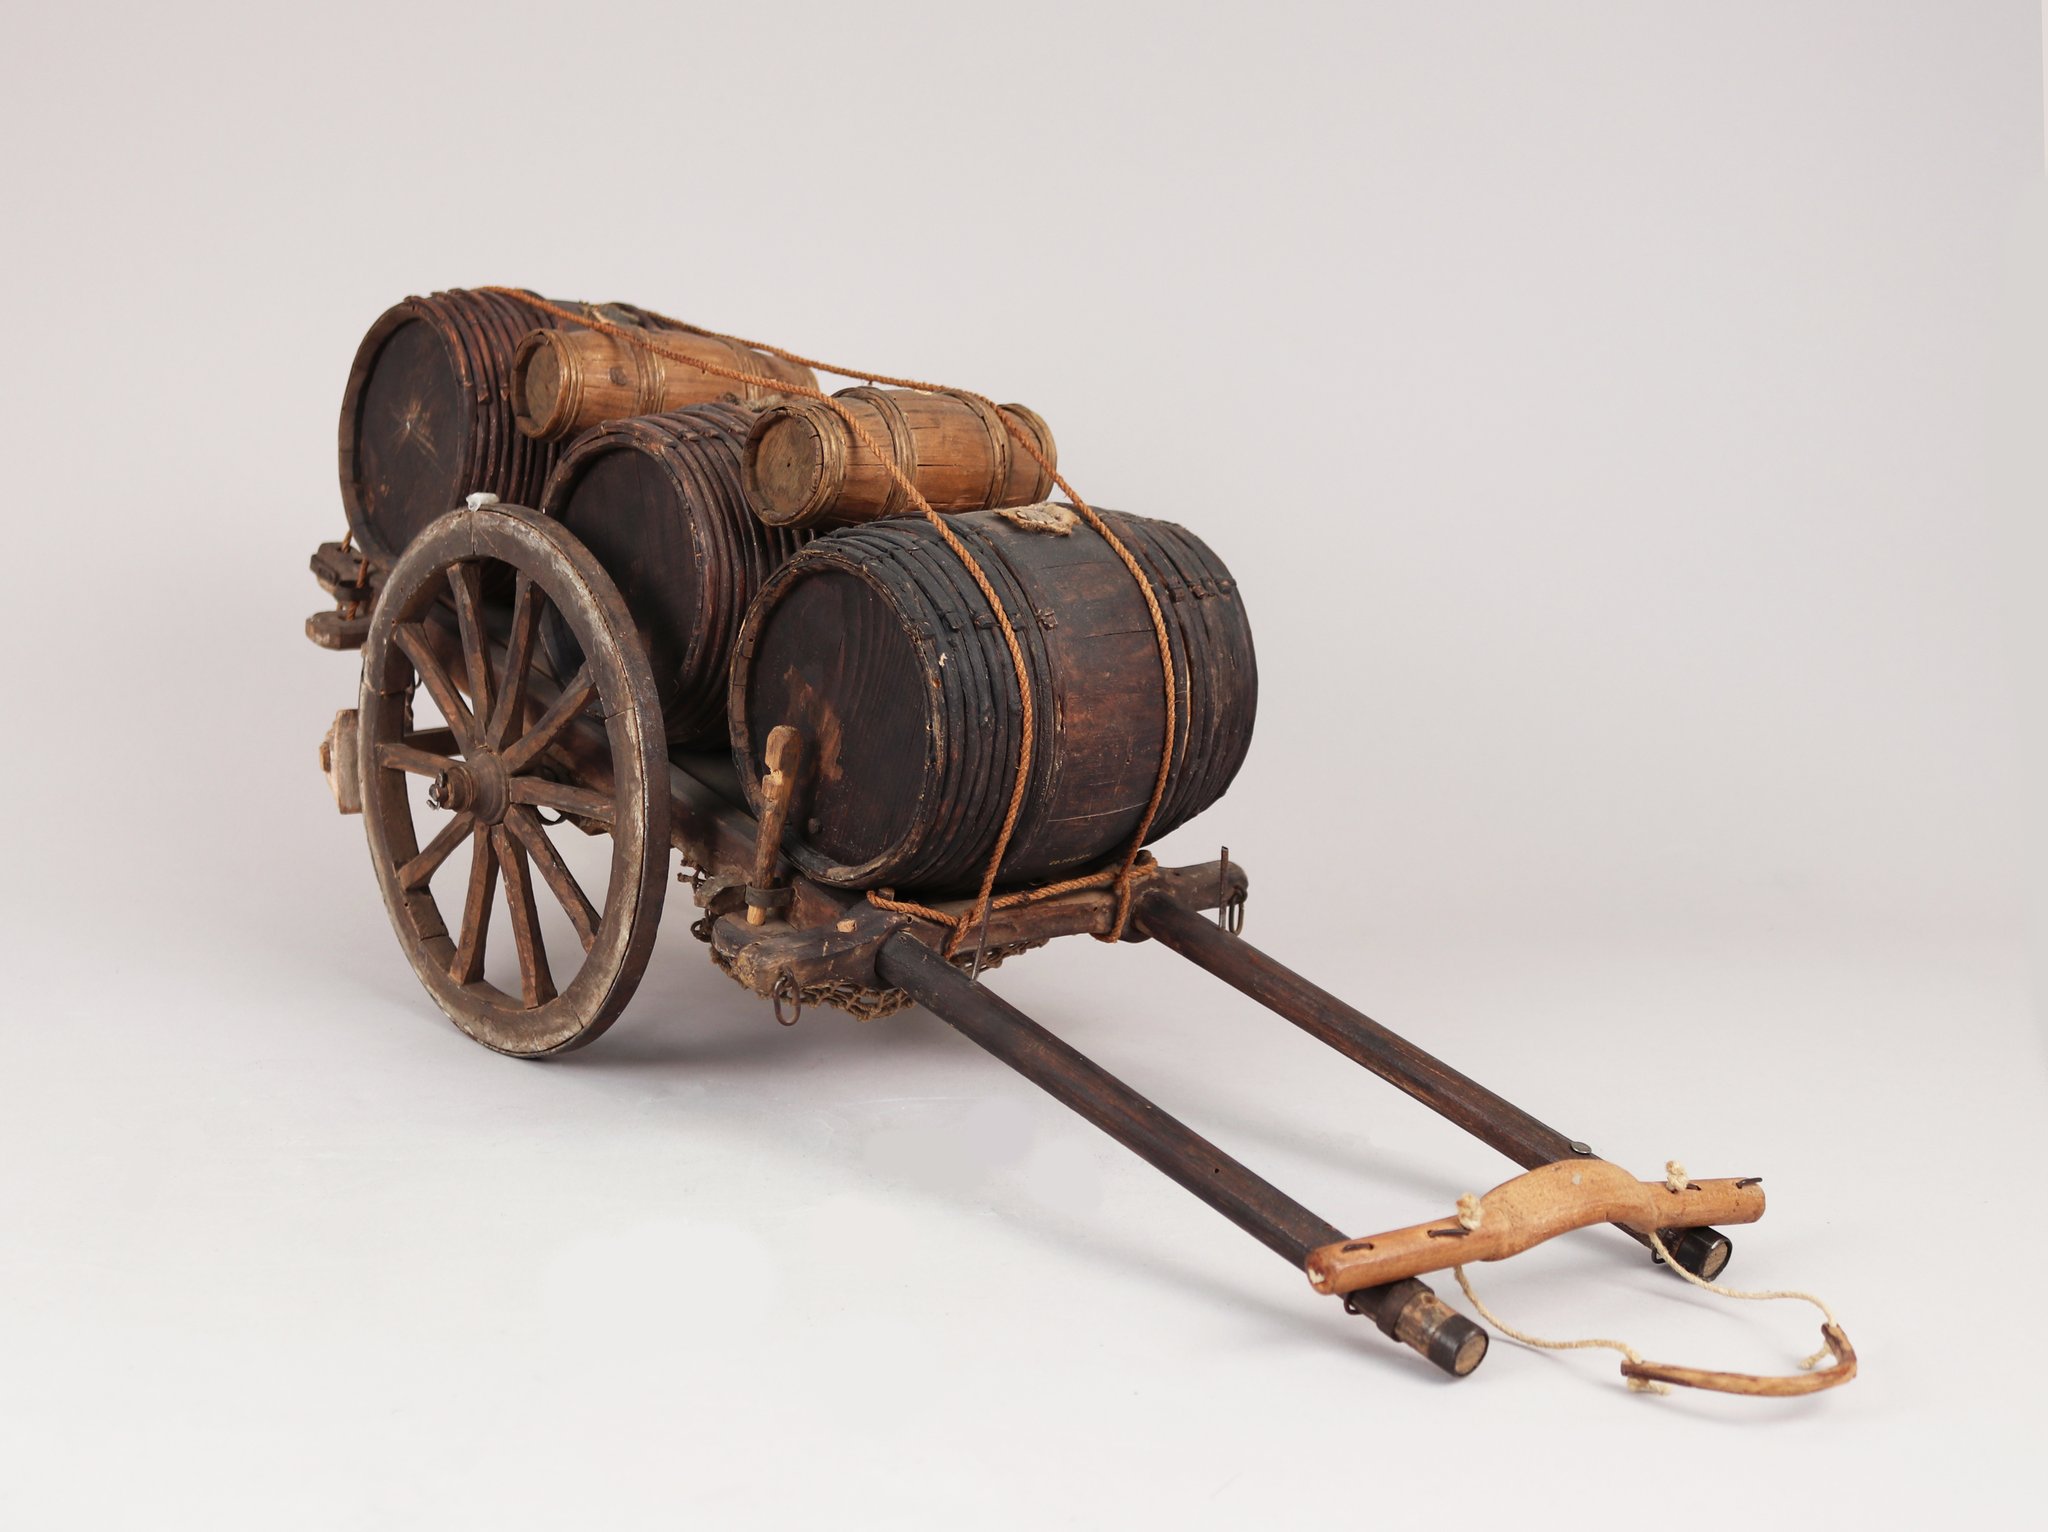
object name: crèche figure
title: Cart and barrels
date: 1701-1800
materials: iron, wood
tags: carts,barrels